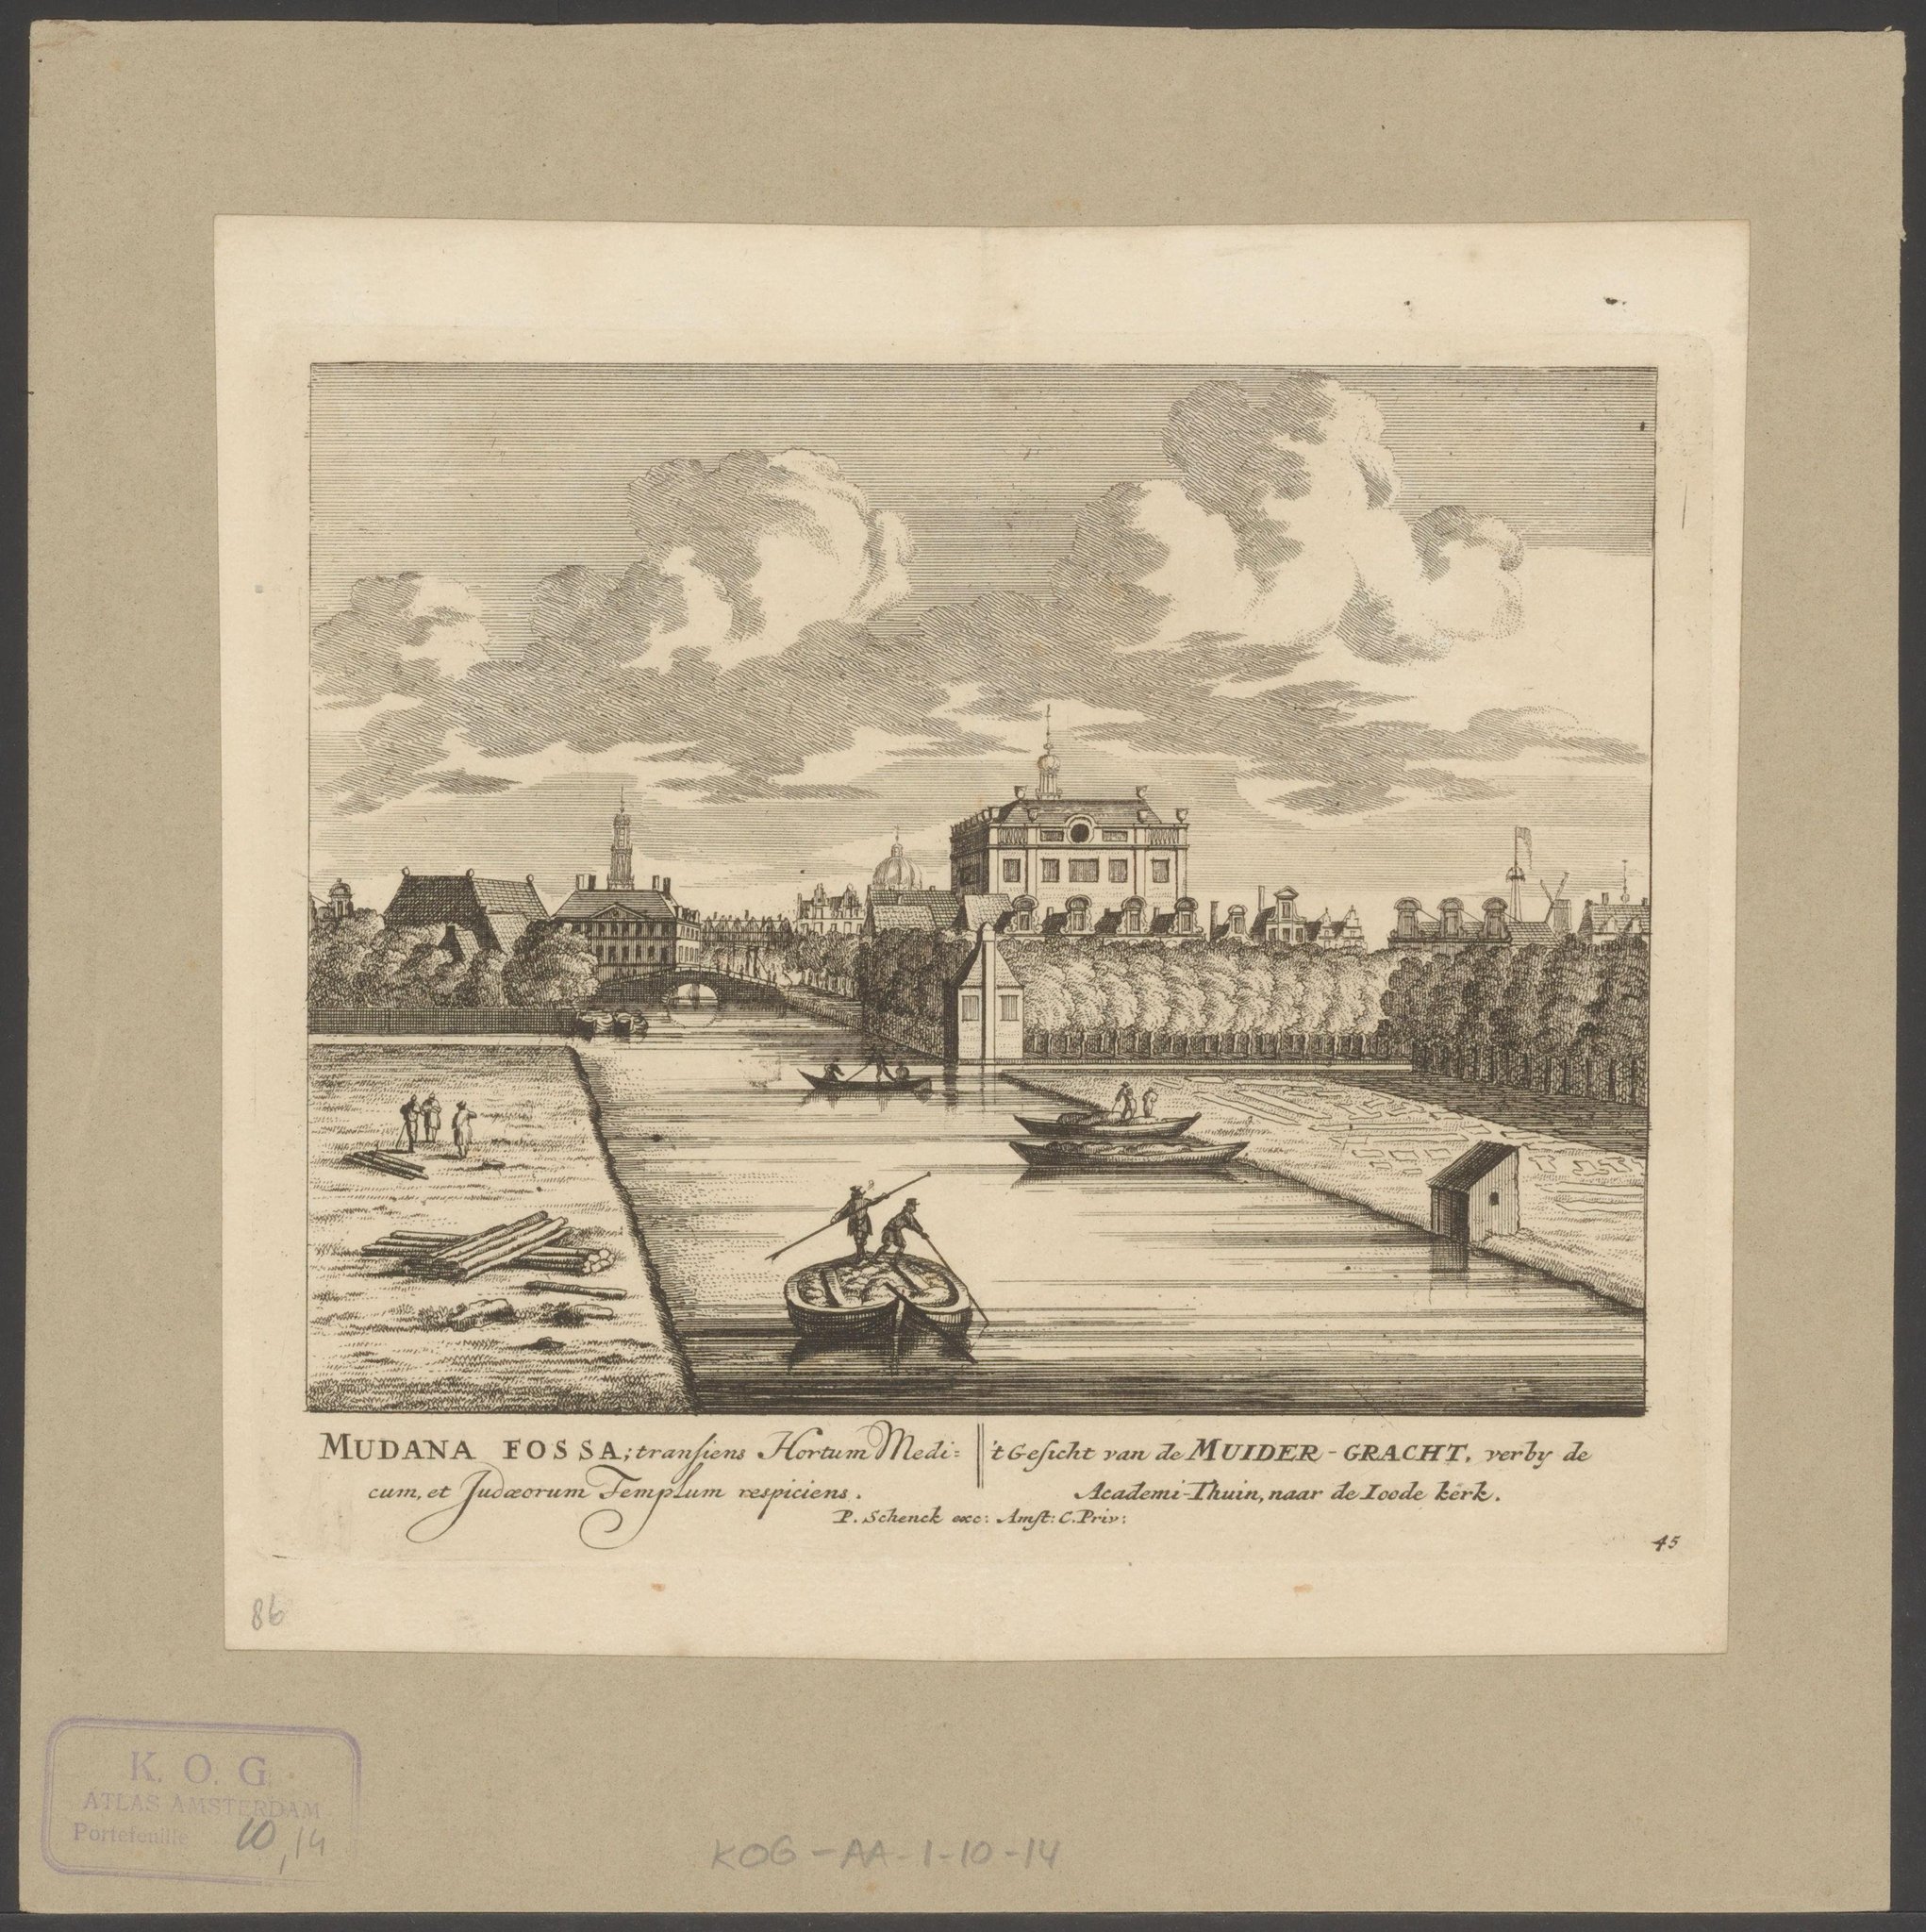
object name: print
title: 100 Afbeeldinge der voornaamste gebouwen van Amsterdam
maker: Anonymous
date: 1710-1711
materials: paper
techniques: etching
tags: city-view in general; 'veduta', the synagogue (as building and place of worship ~ jewish religion), canal, bridge in city across river, canal, etc., boat propelled by man or animal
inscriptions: collector's mark: ‘10,14’ Lugt 1641b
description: Huidige staat van prent ook gebruikt in: 100 Afbeeldinge der voornaamste gebouwen van Amsterdam. Amsterdam, Pieter Schenk (I), s.a. [1710-1711]. En in: 100 Afbeeldinge der voornaamste gebouwen van Amsterdam. Amsterdam, Barent Greve, s.a. [1757-1766].* *In de tweede uitgave, uitgegeven door Barent Greve, is alleen de titelprent aangepast. De overige prenten zijn onveranderd gebleven.